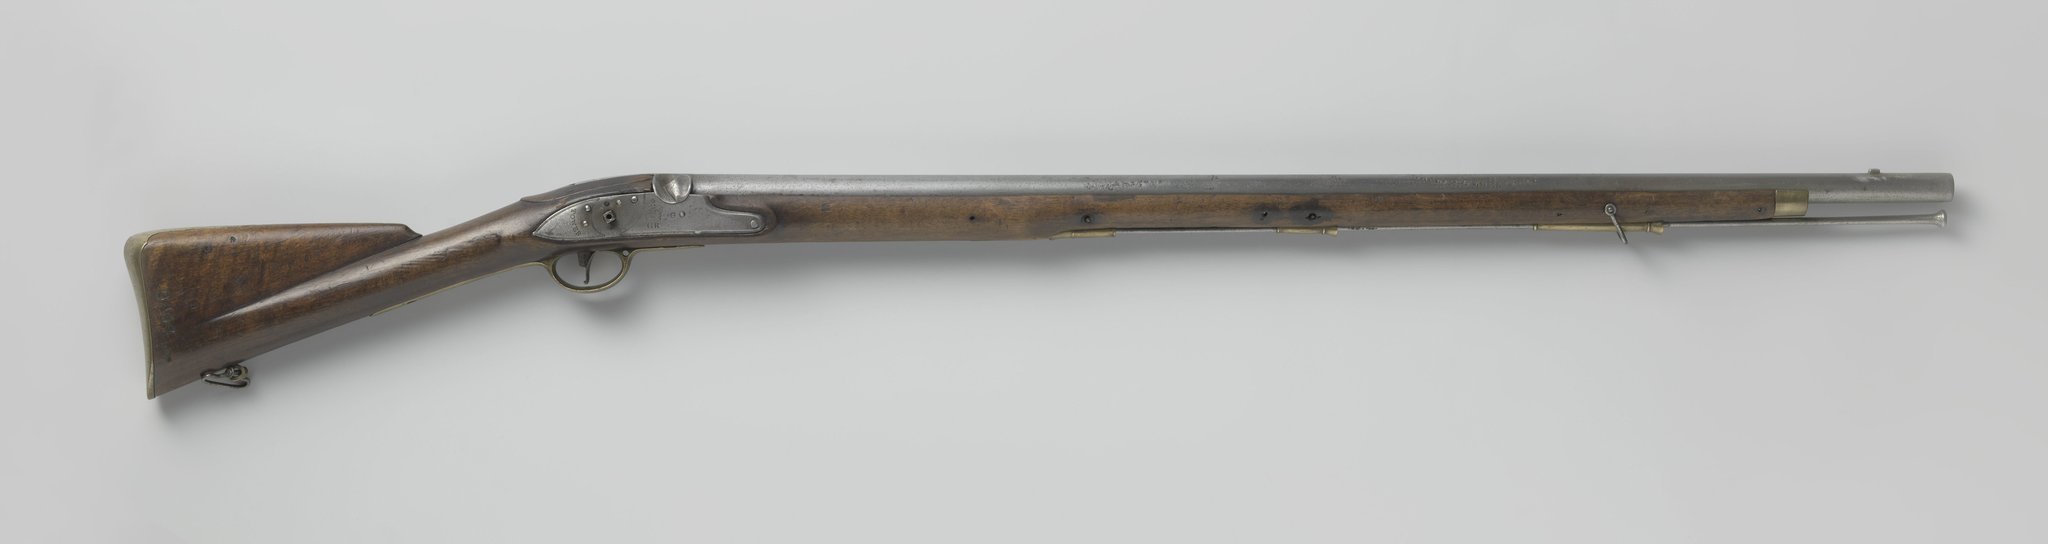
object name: musketon, karabijn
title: Karabijn Engelse dragonders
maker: Anonymous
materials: brass, iron, wood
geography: england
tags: waterloo, england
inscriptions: mark: ‘GR met kroon’, mark: ‘TOWER’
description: Karabijn van de Engelse dragonders, gemerkt op de slotplaat: `GR' onder kroon en `TOWER', controle merk. De karabijn heeft een vaste laadstok en een gladde loop. De haan is gerepareerd. De karabijn is meegebracht van het slagveld van Waterloo door J.J. Nepveu, 2e luitenant bij het 6e Regiment Huzaren.